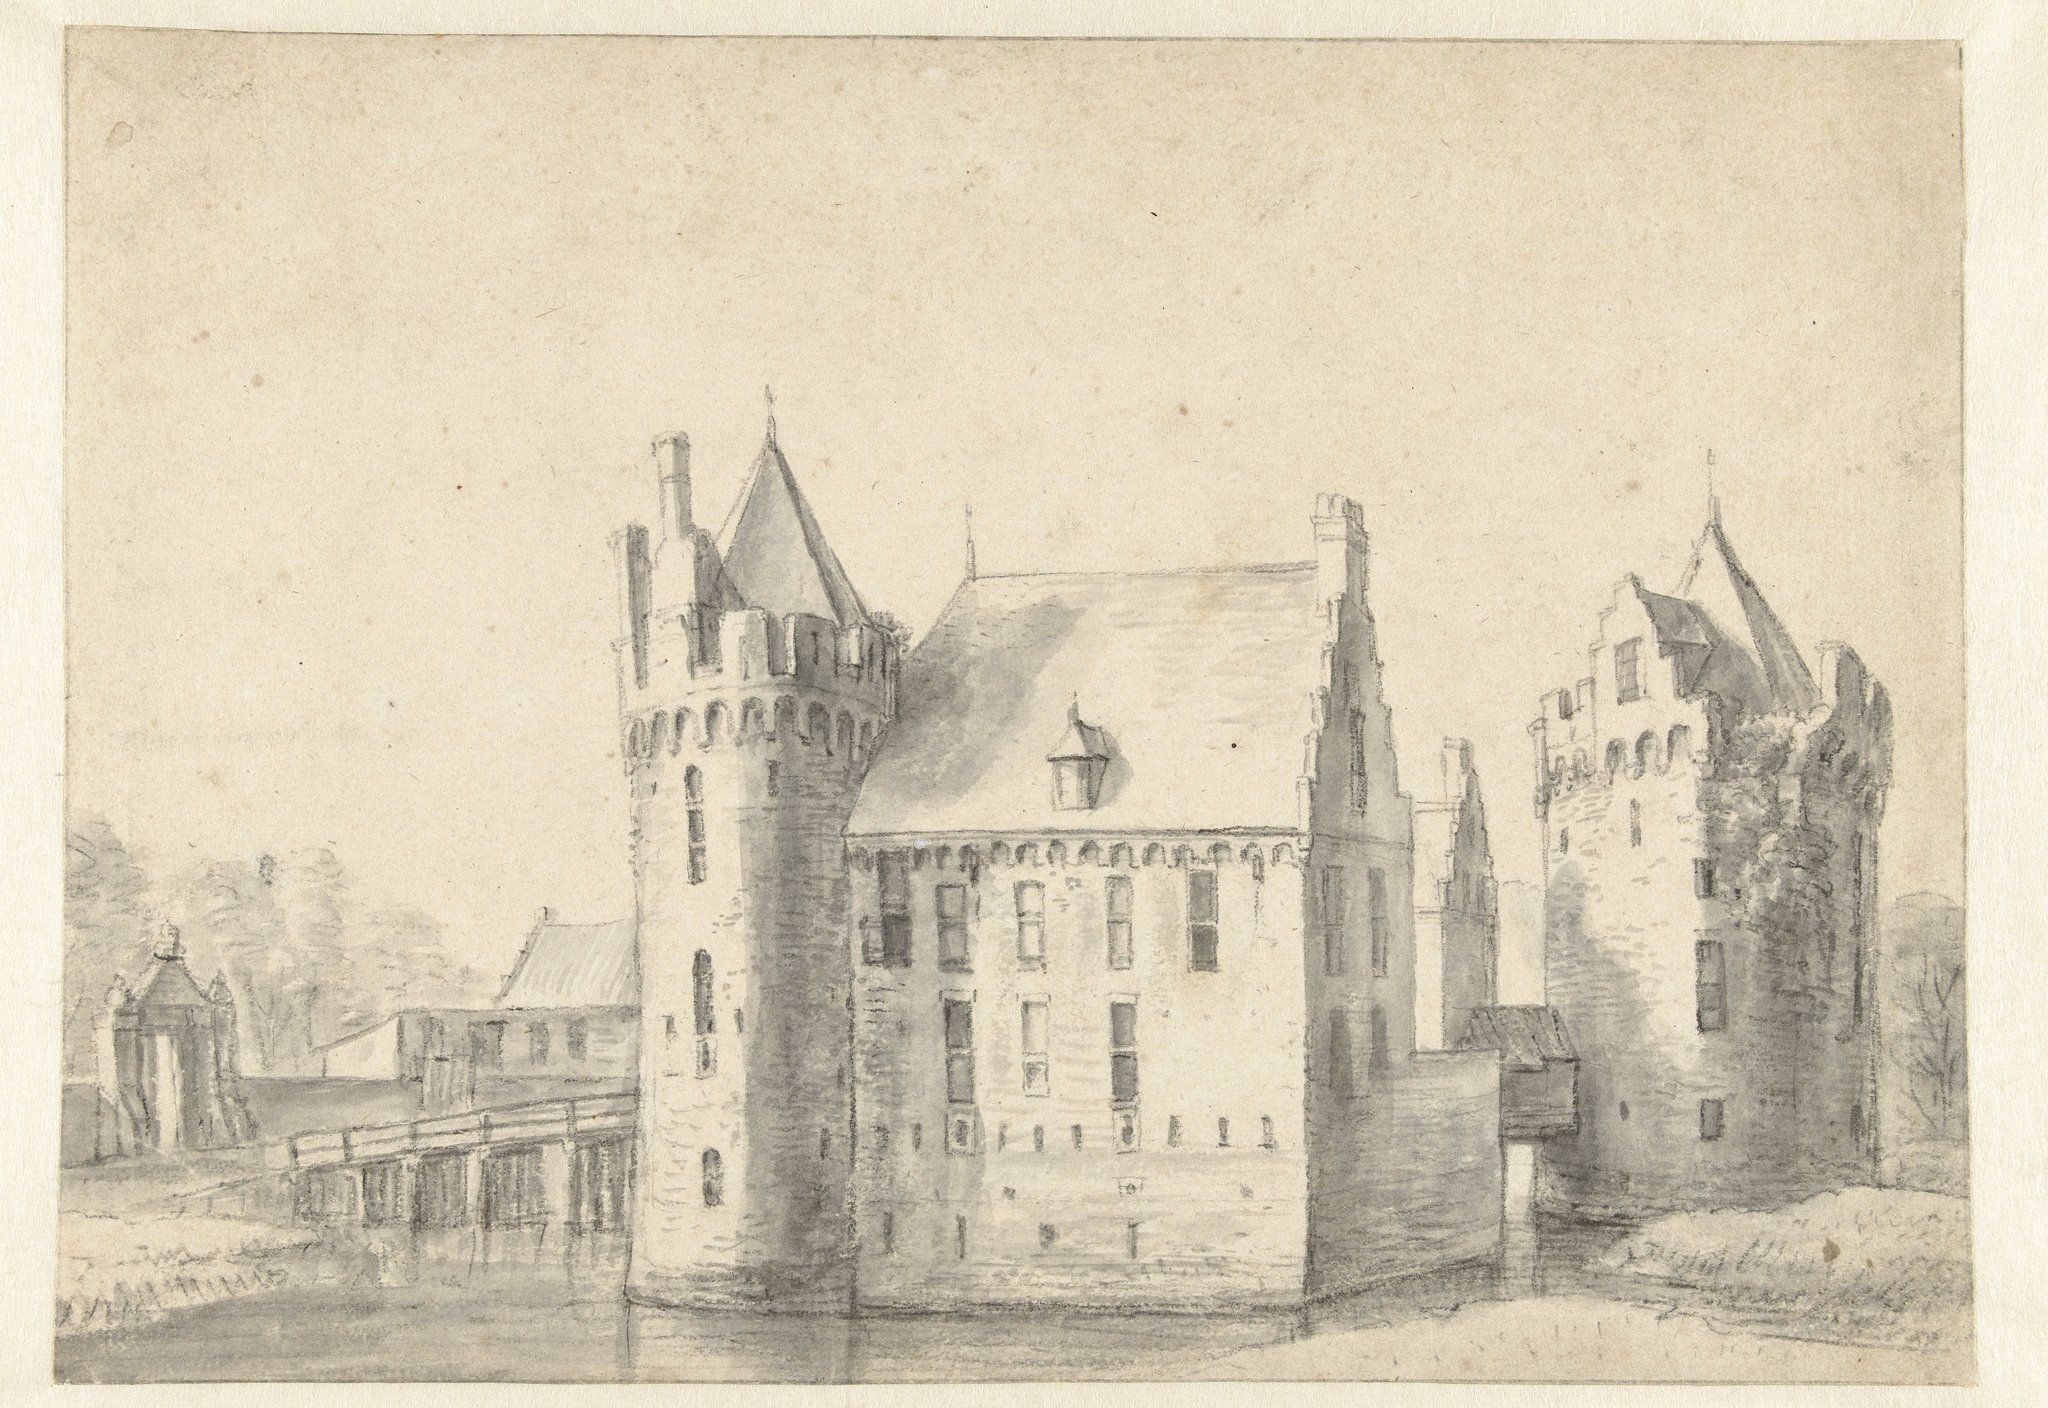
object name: drawing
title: Gezicht op het Sjaerdemaslot te Franeker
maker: anthonie waterloo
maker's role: draughtsman, painter, print maker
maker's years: 1609-1690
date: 1619-1690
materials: chalk, paper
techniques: brush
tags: castle